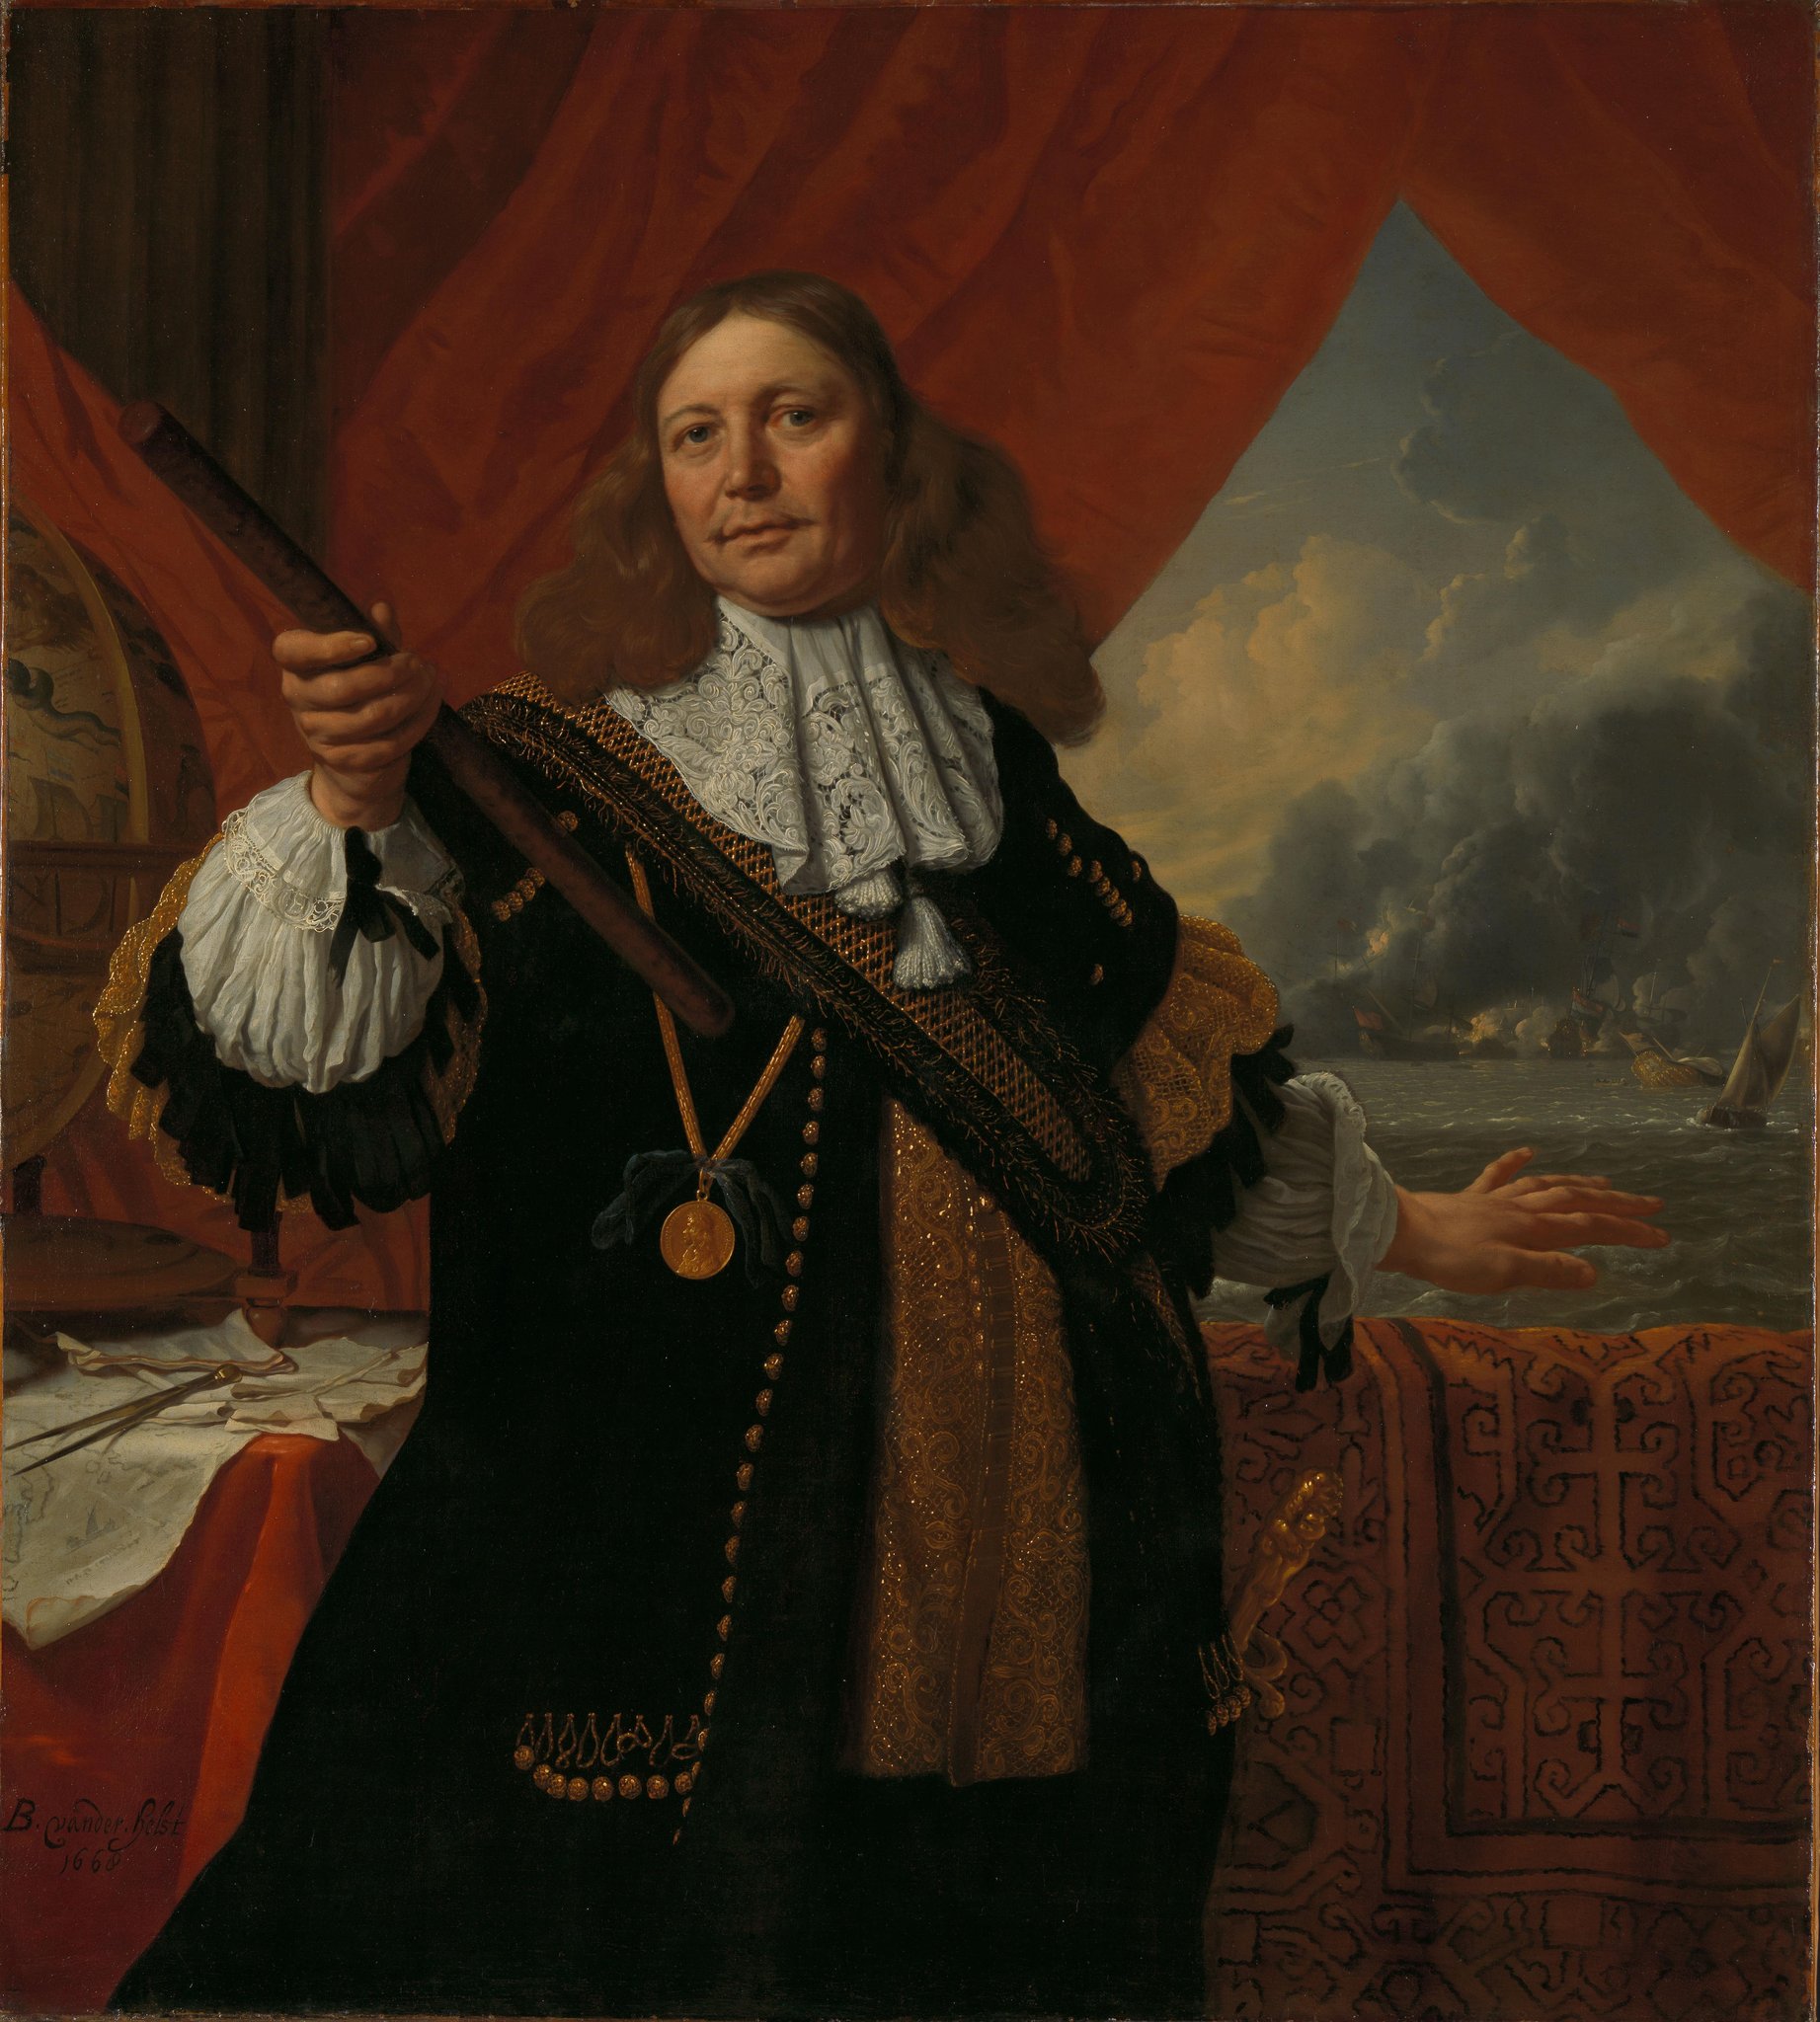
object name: painting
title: Johan de Liefde (ca. 1619-73), Vice-Admiral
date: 1668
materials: canvas, oil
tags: johan de liefde, historical persons, commander-in-chief, admiral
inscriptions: signature and date: ‘B. vander helst 1668’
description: Johan de Liefde by Bartholomeus van der Helst, 1668. Johan de Liefde (c. 1619-1673) played a key role in the capture of the English flagship, the Royal Charles, in 1667. In honour of the victory he received a gold chain with a commemorative medal. Van der Helst portrayed him in all his finery, wearing the chain. The background, with the battle, was painted by Ludolf Bakhuysen. De Liefde, who was made lieutenant admiral in 1666, was killed in the Battle of Kijkduin off the coast of Holland during the Third Anglo-Dutch War (1672-1674).